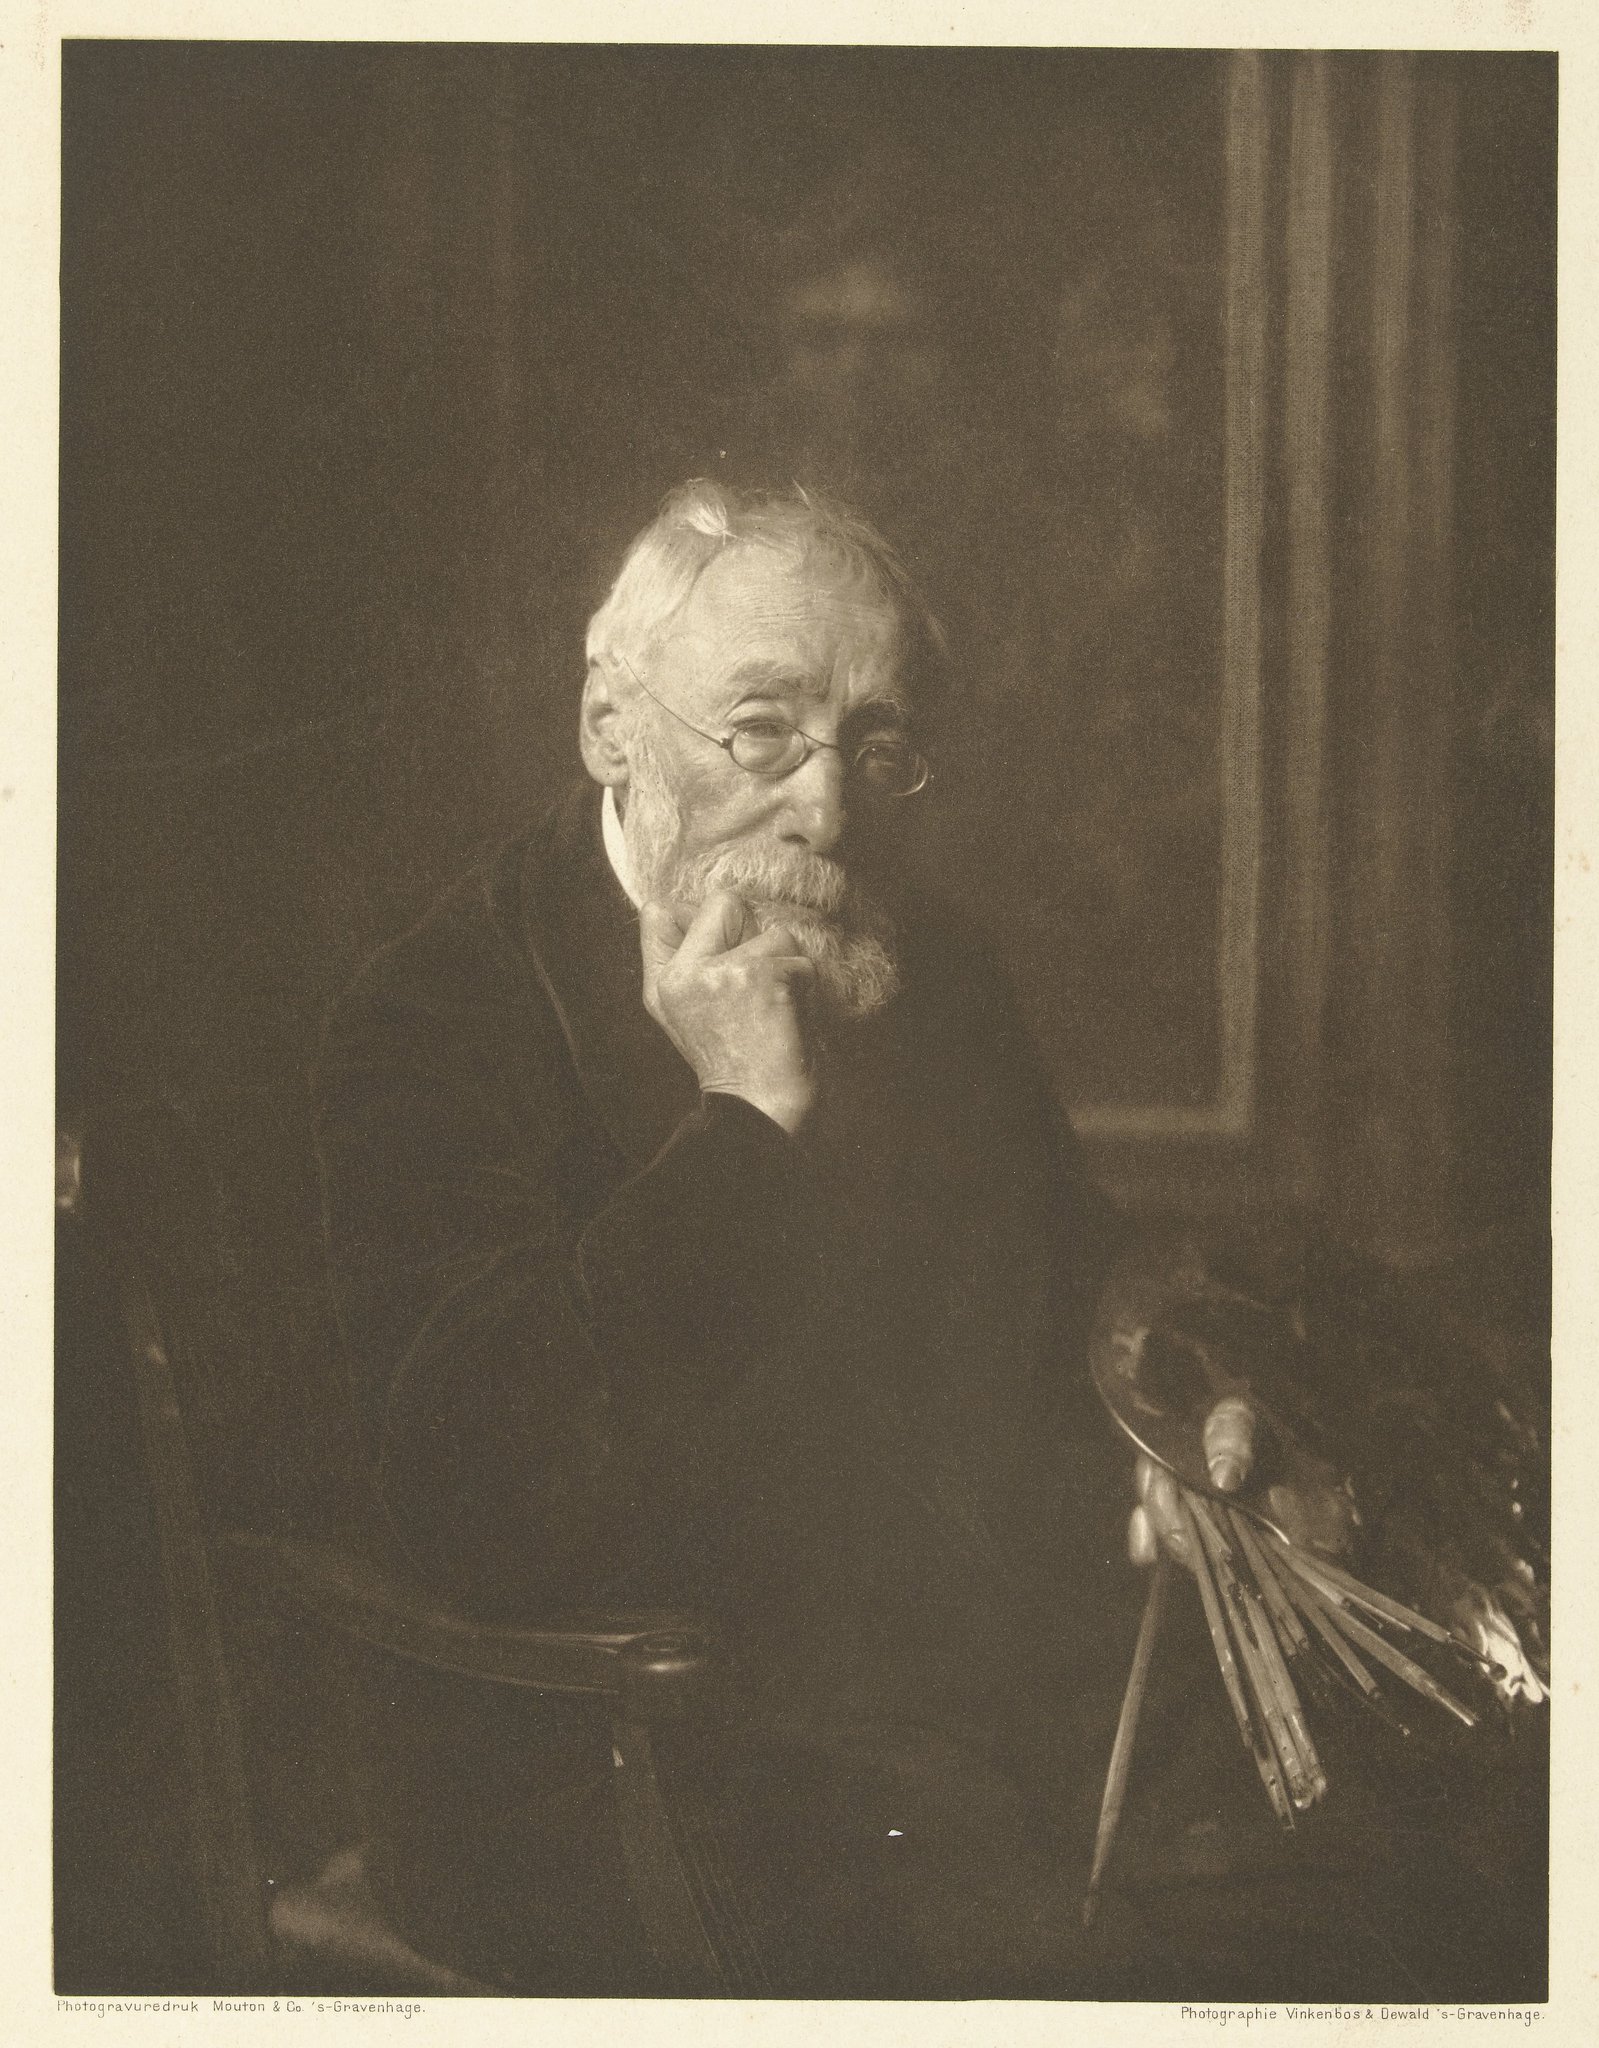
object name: photograph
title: Portret van Jozef Israëls in zijn atelier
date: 1904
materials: cardboard, paper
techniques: photoaquatint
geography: the hague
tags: print maker, draughtsman, jozef israëls, historical persons, portrait, self-portrait of painter